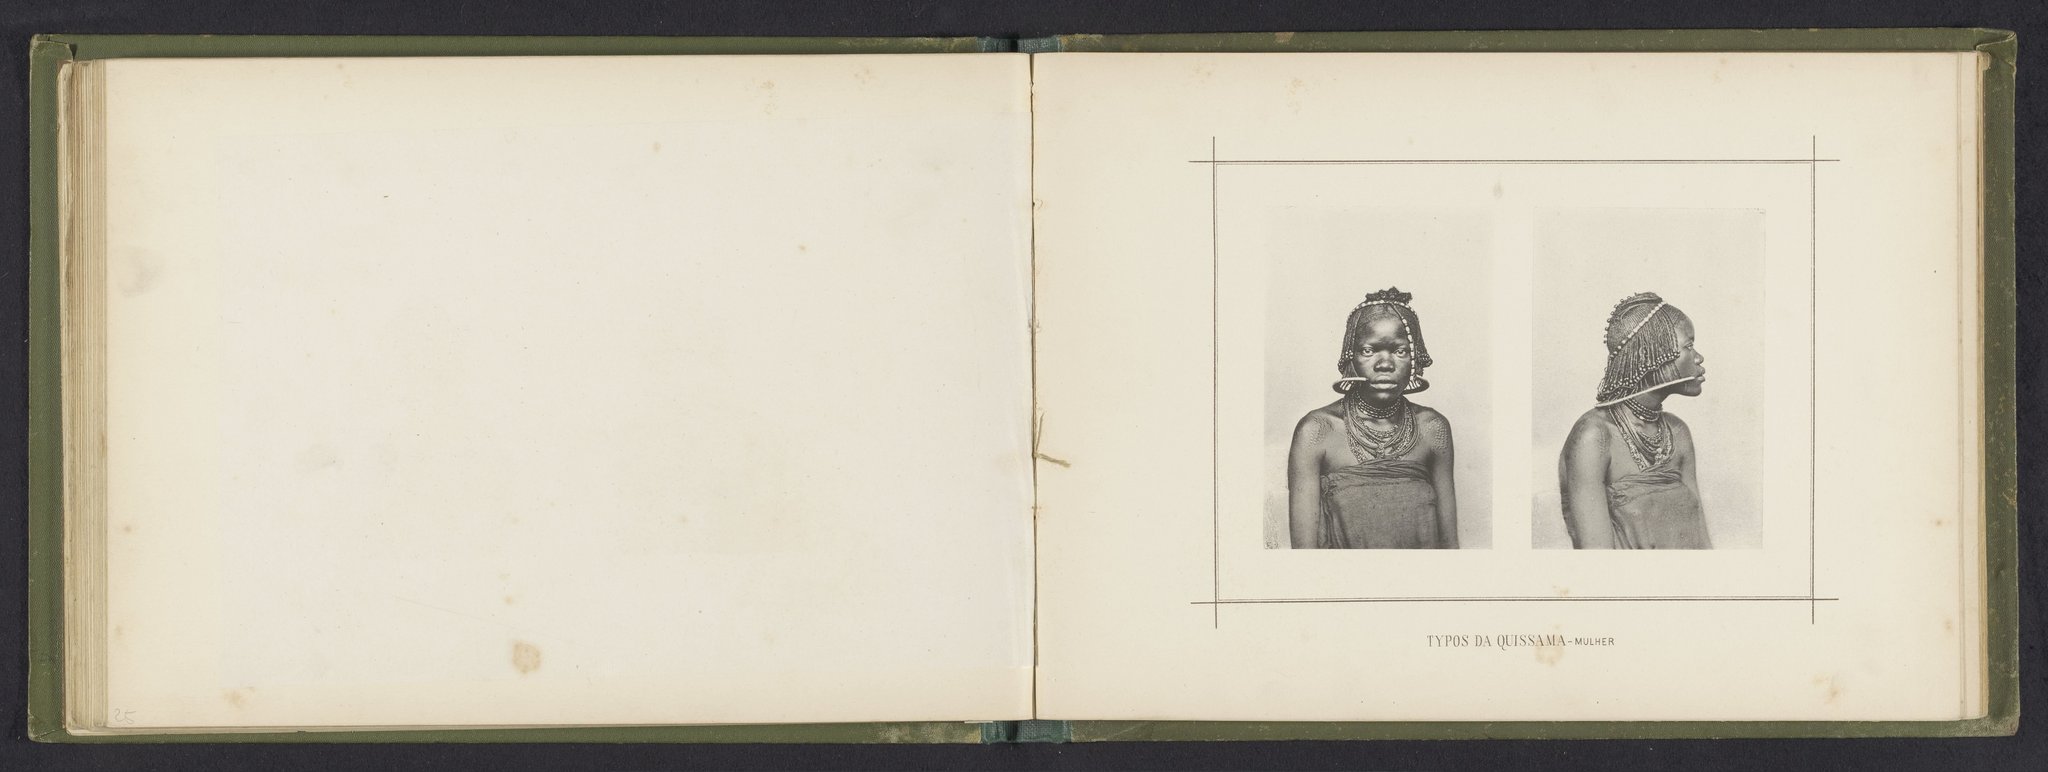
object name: photomechanical print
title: Typos da Quissama-mulher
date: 1876-1886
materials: paper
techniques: photograph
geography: quiçama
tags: anonymous historical person portrayed alone - bb - woman, necklace